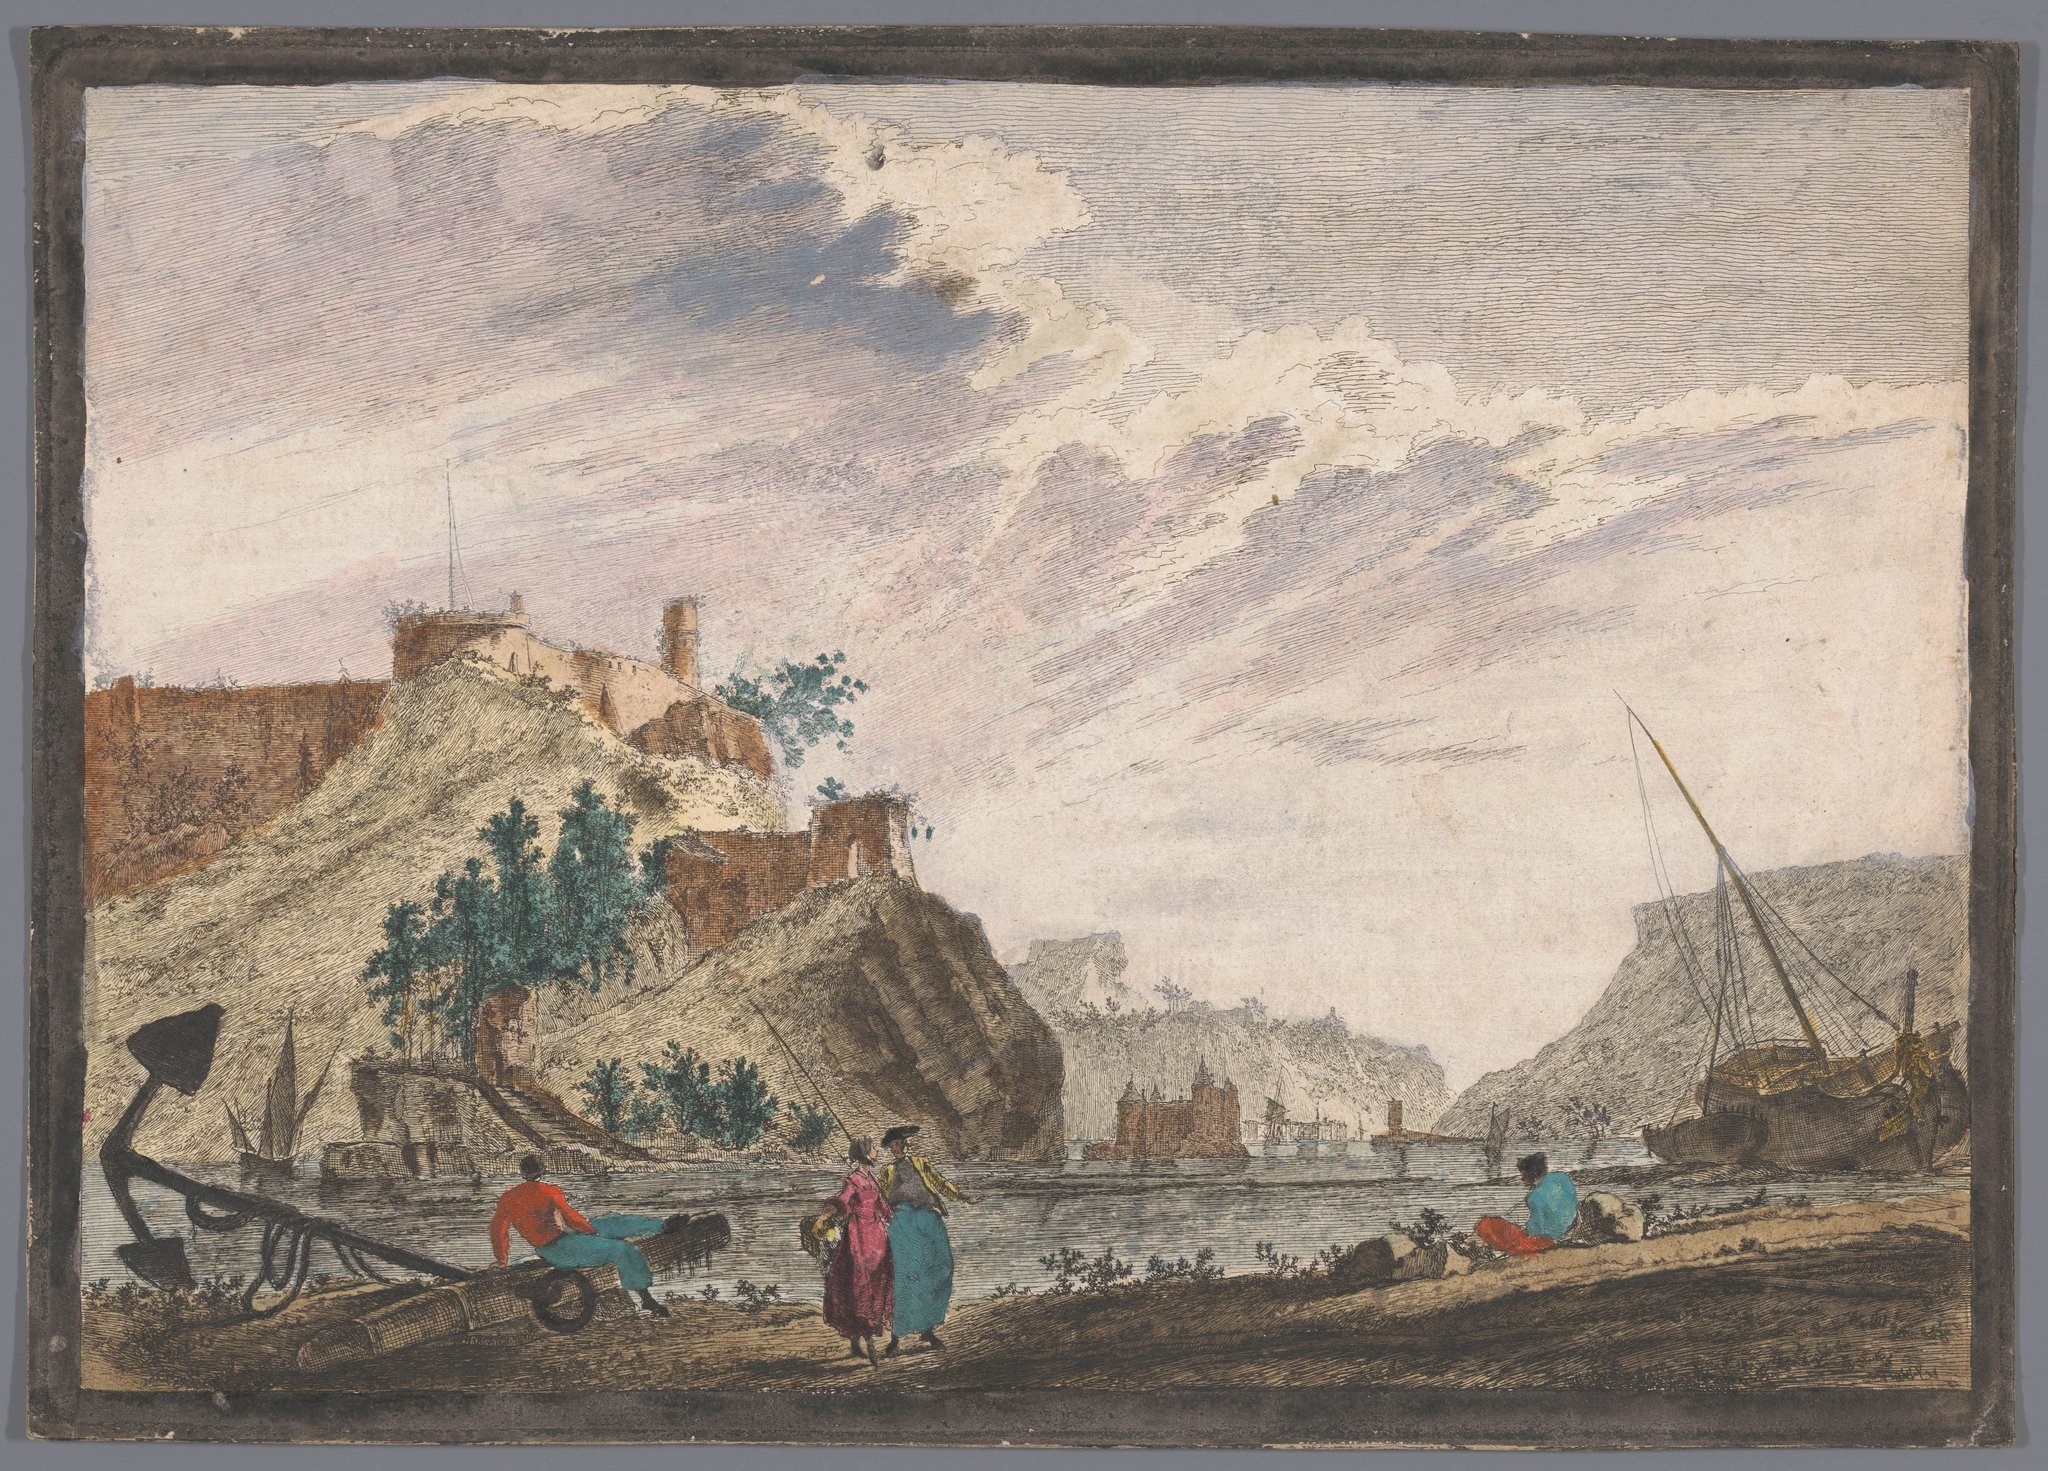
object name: opticaprent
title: Gezicht op een haven met rotsen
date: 1700-1799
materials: cardboard, paper, watercolor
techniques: brush, etching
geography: france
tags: harbour, sailing-ship, sailing-boat, rocky coast, rowing-boat, canoe, etc., sea (seascape) (+ landscape with figures, staffage), civic architecture; edifices; dwellings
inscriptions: collector's mark: Lugt 2233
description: Links en in het midden versterkte bouwwerken aan de waterkant. Op de voorgrond een anker.